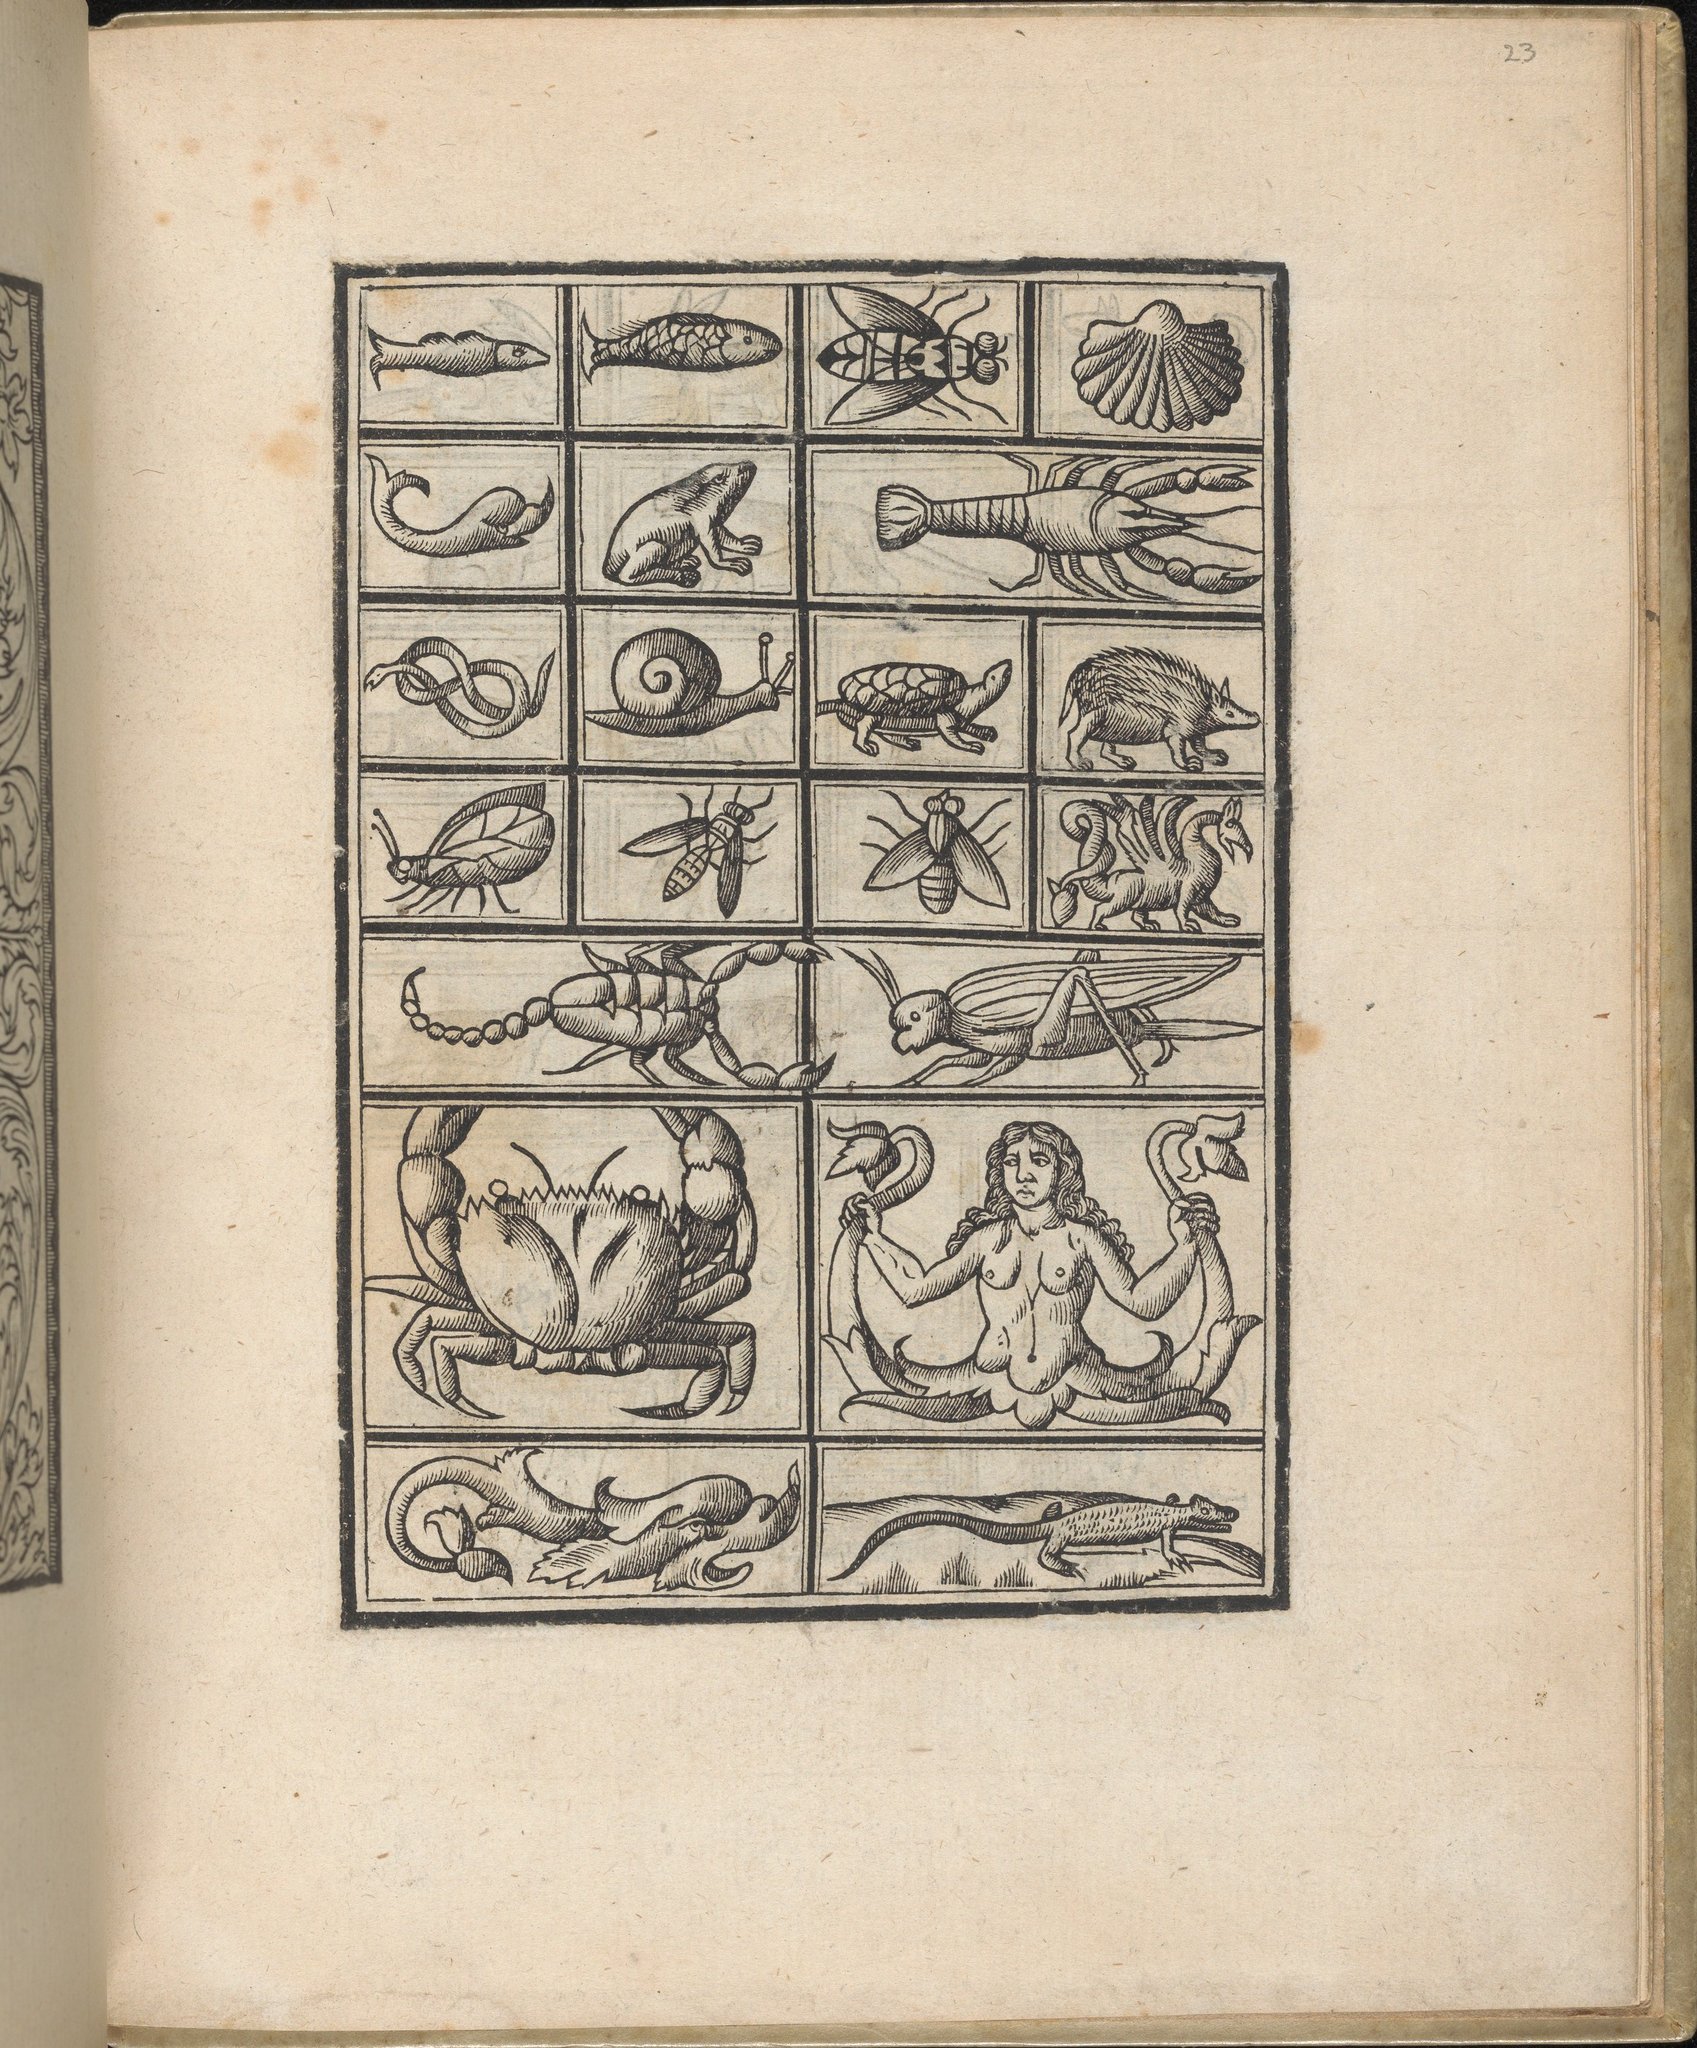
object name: book print ornament architecture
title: Trionfo Di Virtu. Libro Novo..., page 23 (verso)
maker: matteo pagano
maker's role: publisher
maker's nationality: italian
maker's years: 1515-1588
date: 1563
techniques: woodcut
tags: crabs,fish,scorpions